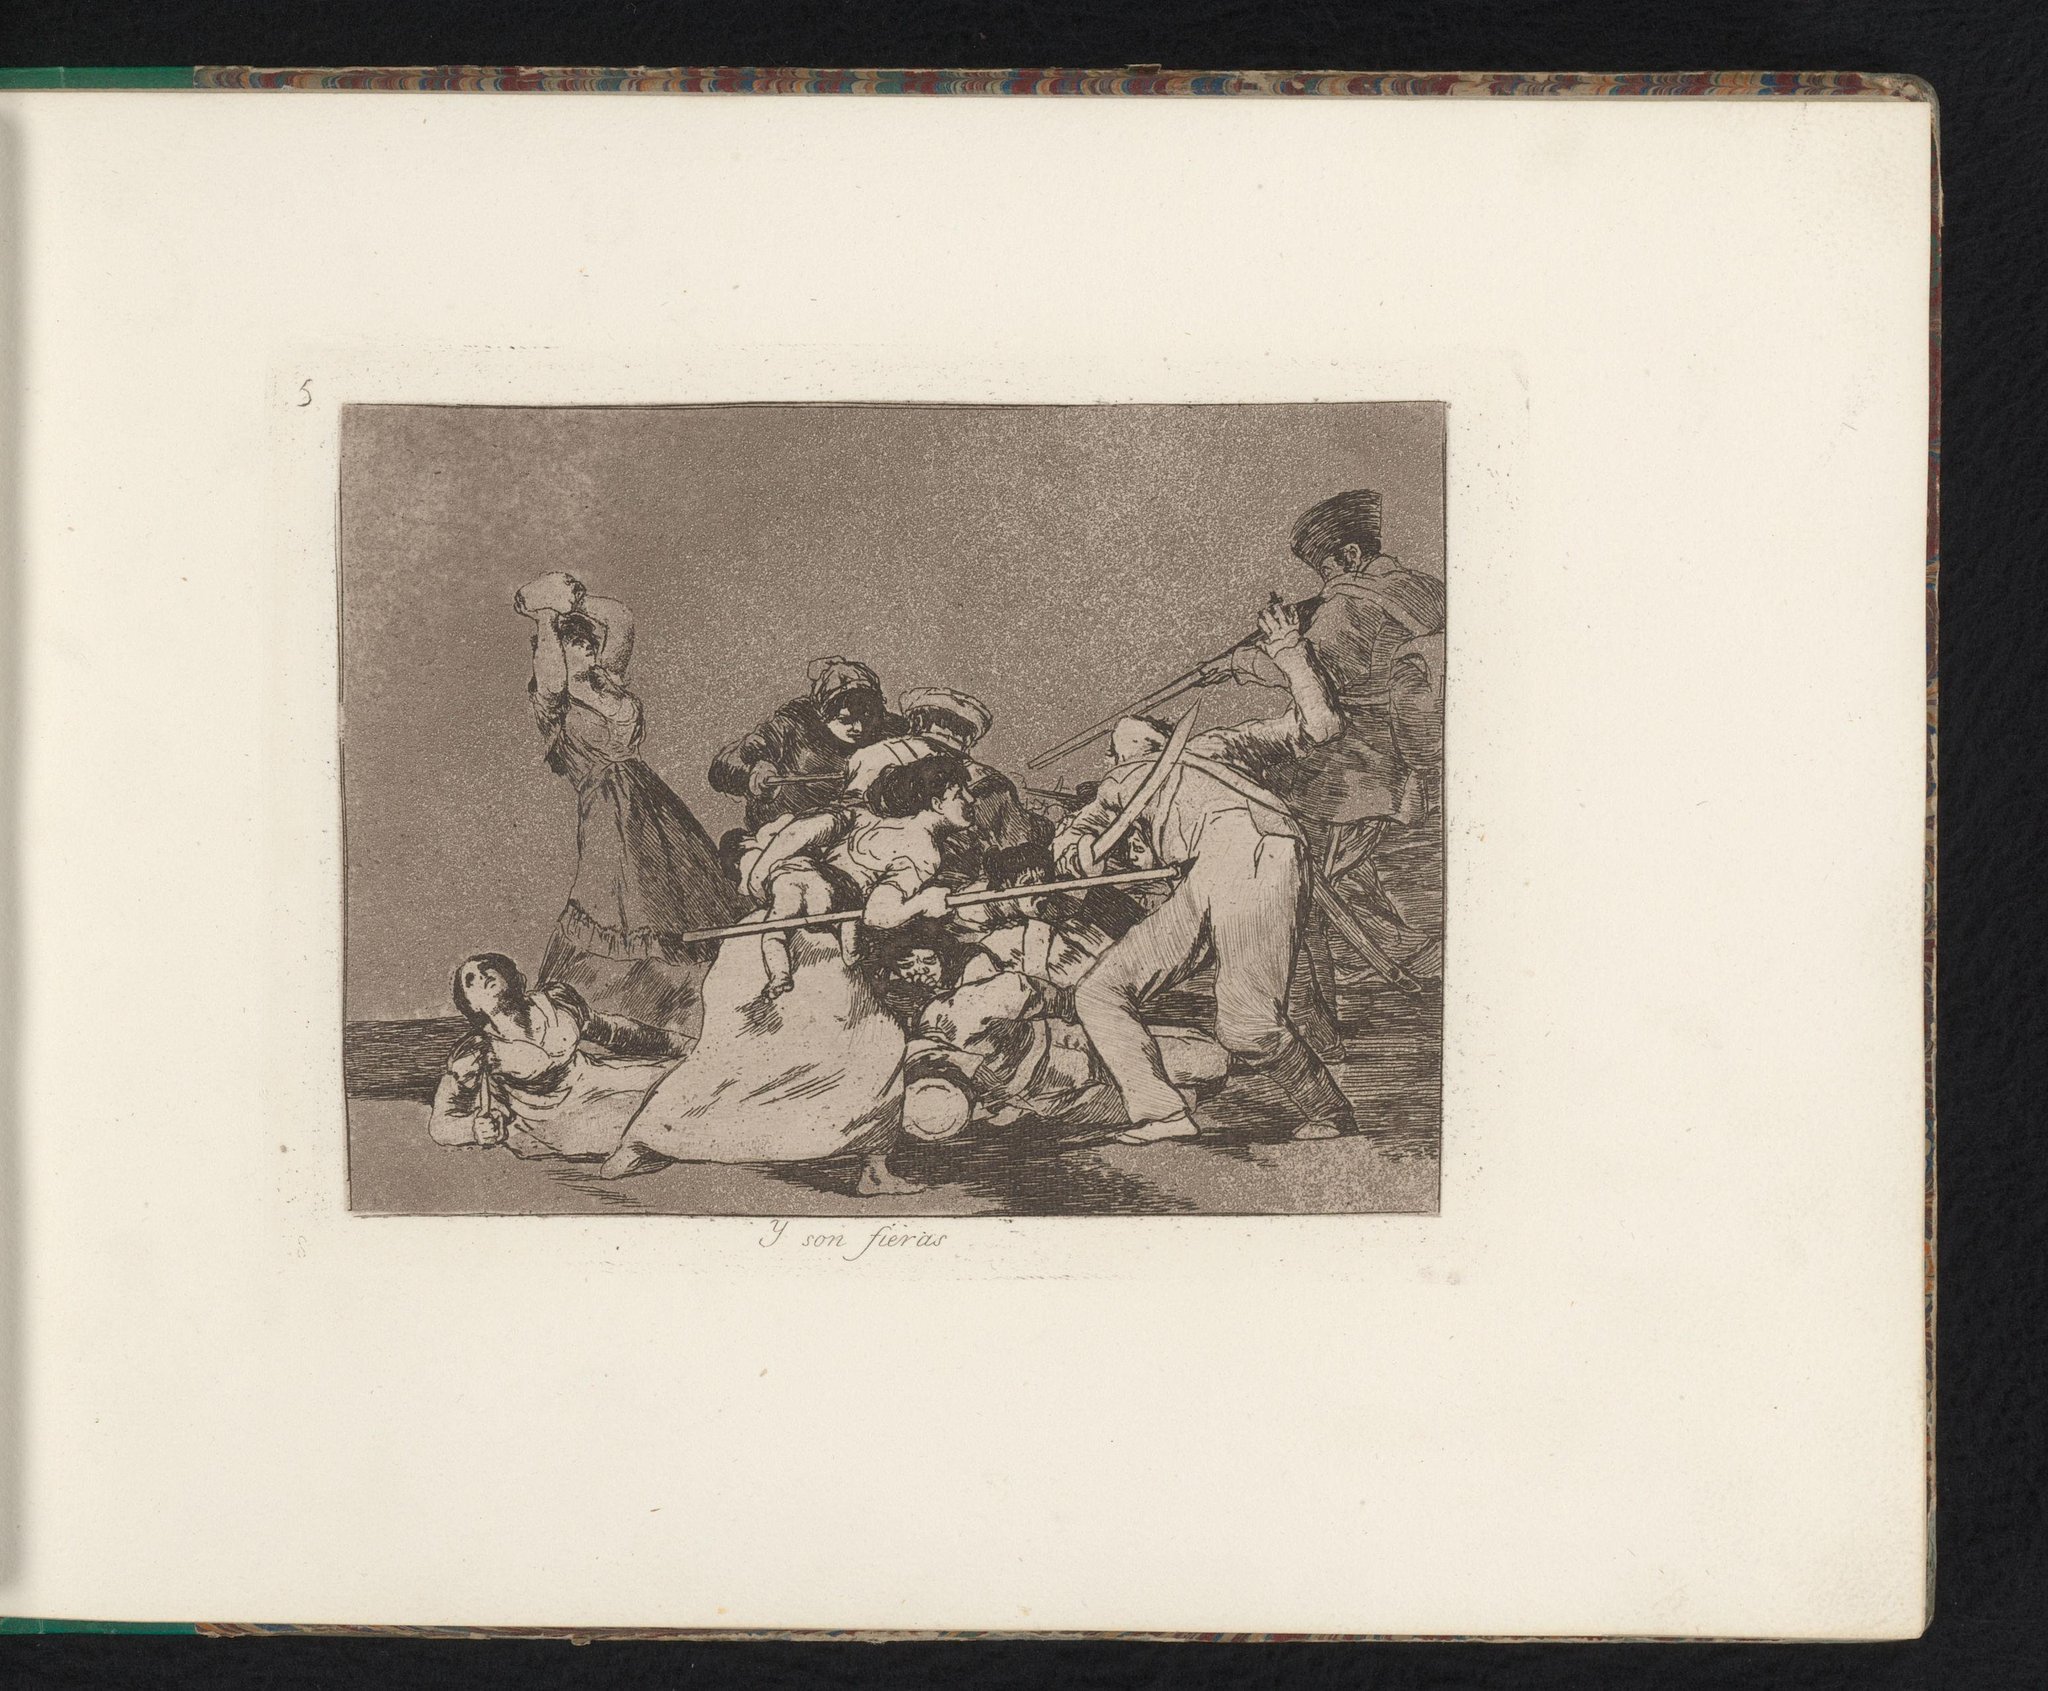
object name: album leaf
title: Gruwelen van de oorlog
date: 1810-1820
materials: paper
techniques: aquatint, drypoint, etching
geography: madrid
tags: mother and baby or young child, horrors of war, violent death by lance, spear, spain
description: Deze prent maakt deel uit van een album.